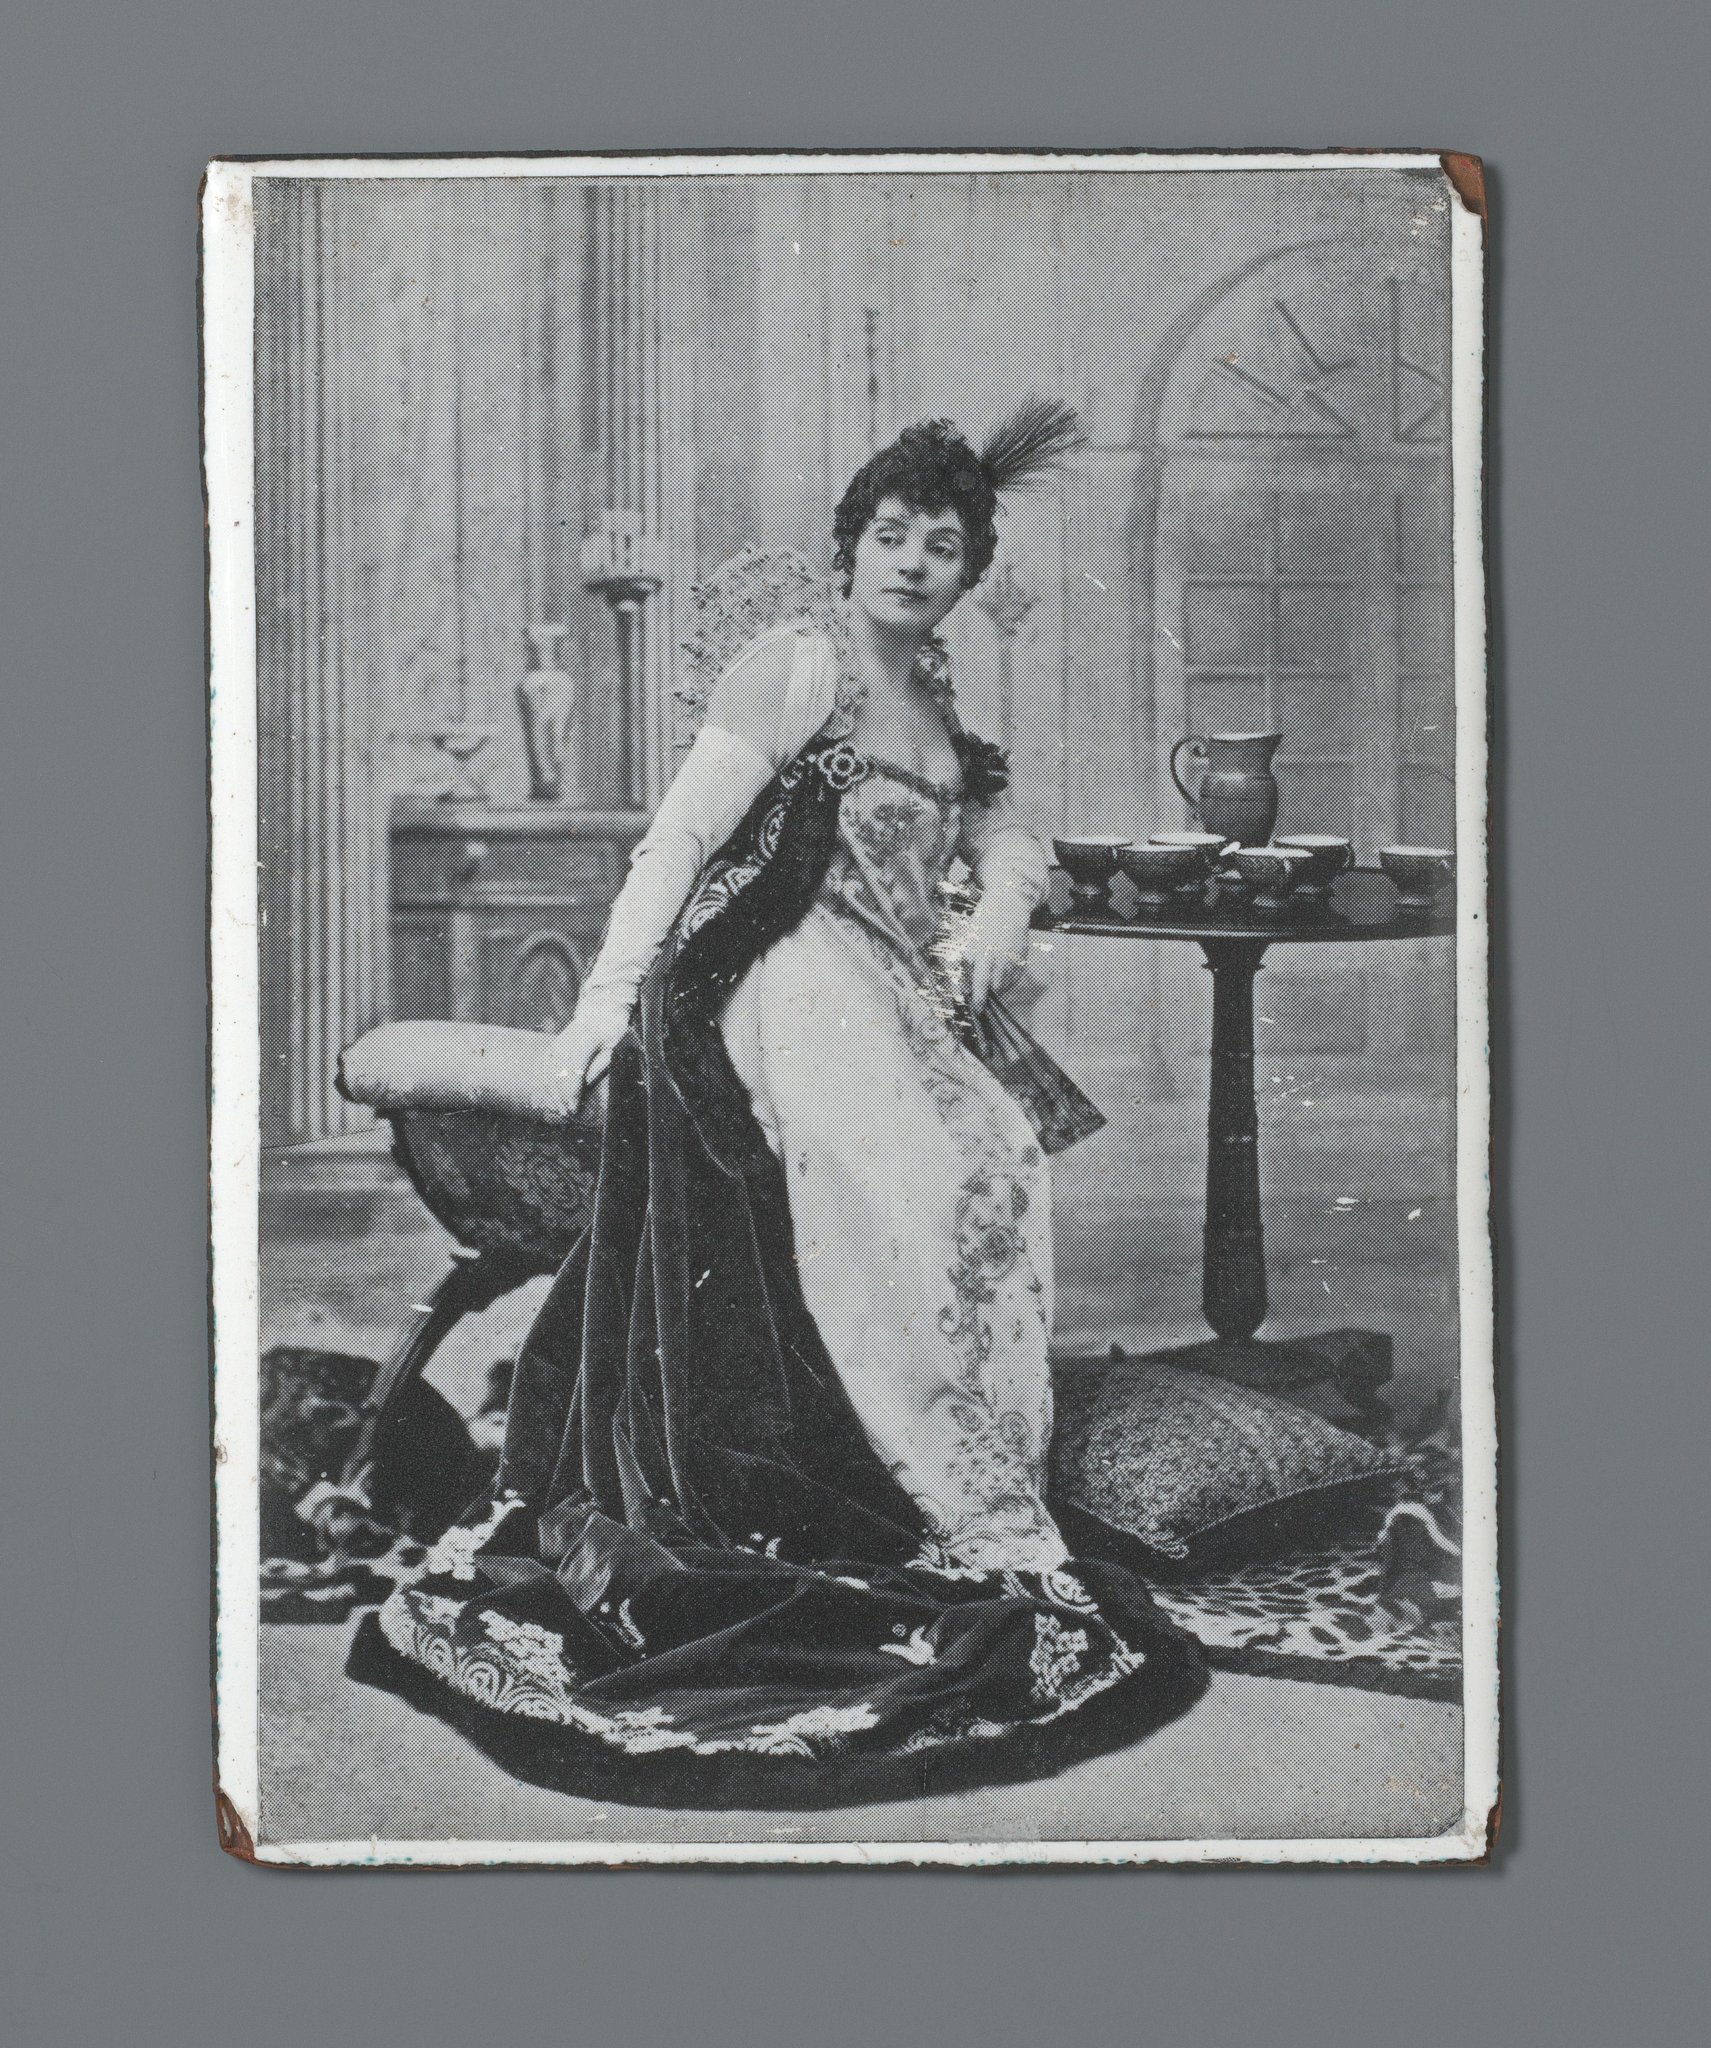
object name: photomechanical print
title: Portret van een onbekende vrouw in japon met sleep in interieur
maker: Anonymous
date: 1875-1900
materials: enamel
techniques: autotype, enamel photograph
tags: anonymous historical person portrayed, dress, gown, cup of tea, france